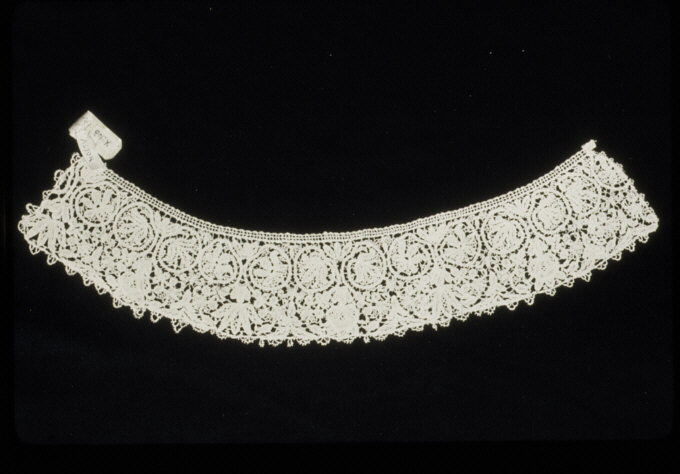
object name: collar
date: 1650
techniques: lace